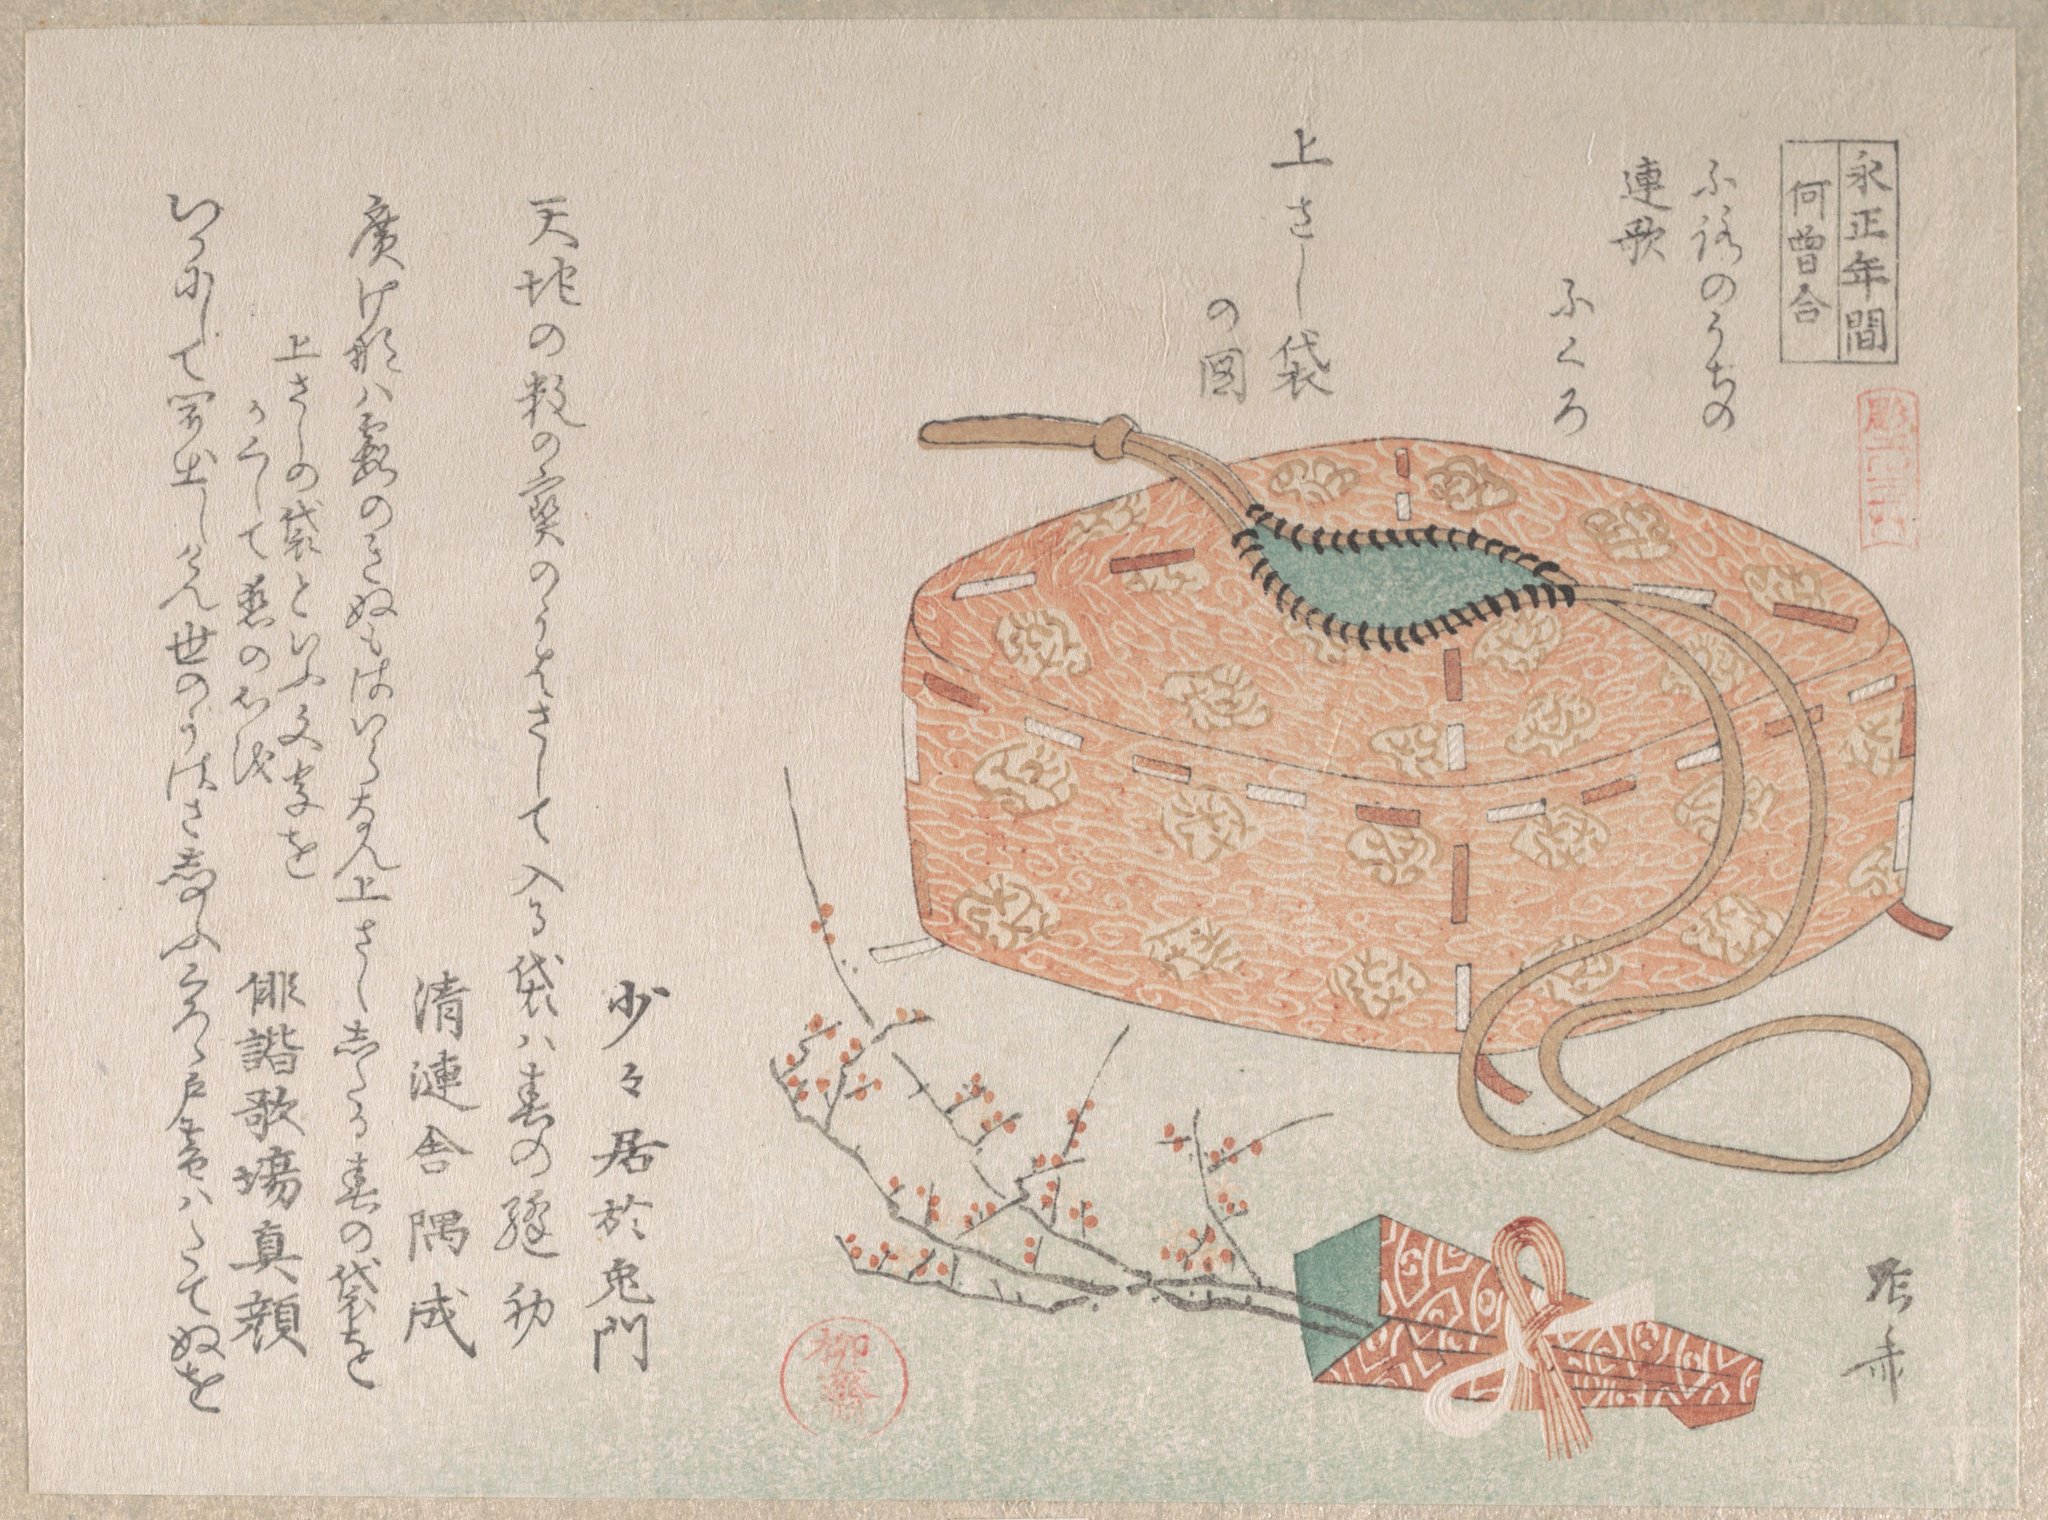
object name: woodblock print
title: Cloth Bag with Cords and Plum Blossoms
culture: japanese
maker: ryūryūkyo shinsai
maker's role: artist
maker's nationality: japanese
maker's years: 1799-1823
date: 1801-1900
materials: ink, paper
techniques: surimono, woodblock print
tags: flowers